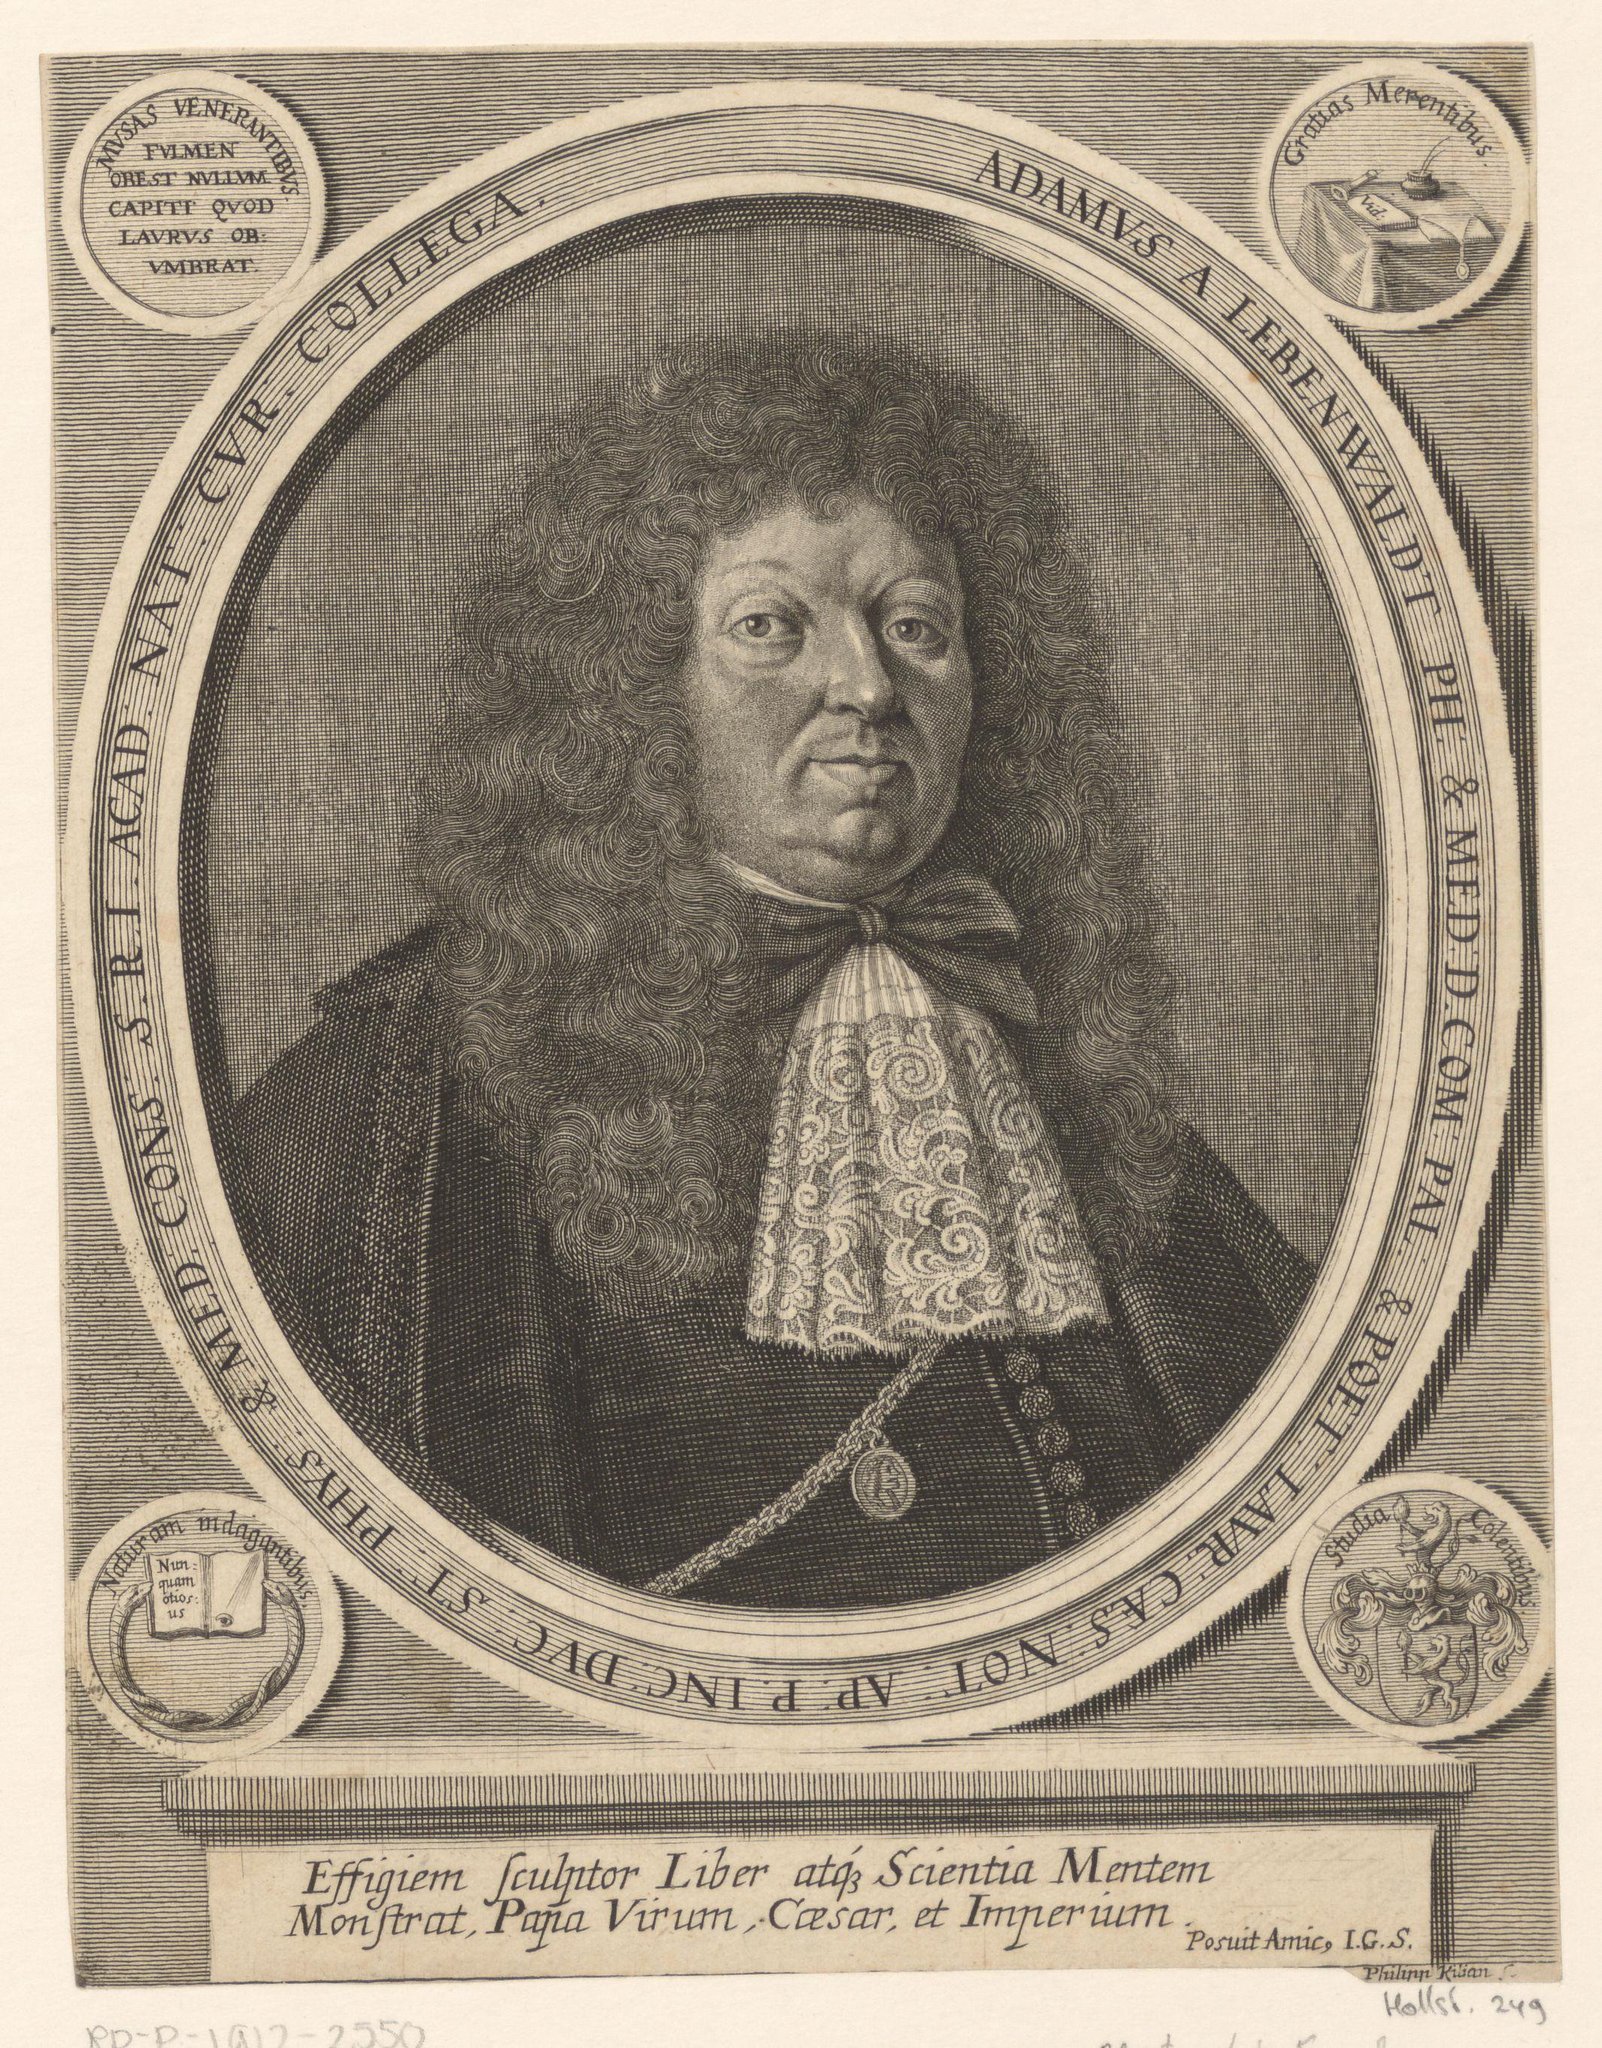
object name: print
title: Portret van Adam von Lebenwaldt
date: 1638-1693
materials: paper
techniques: engraving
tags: historical persons, writer, poet, author, physician, doctor (+ portrait of scholar, scientist)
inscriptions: collector's mark: Lugt 2228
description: Tekst in het Latijn in de omlijsting en op de sokkel.